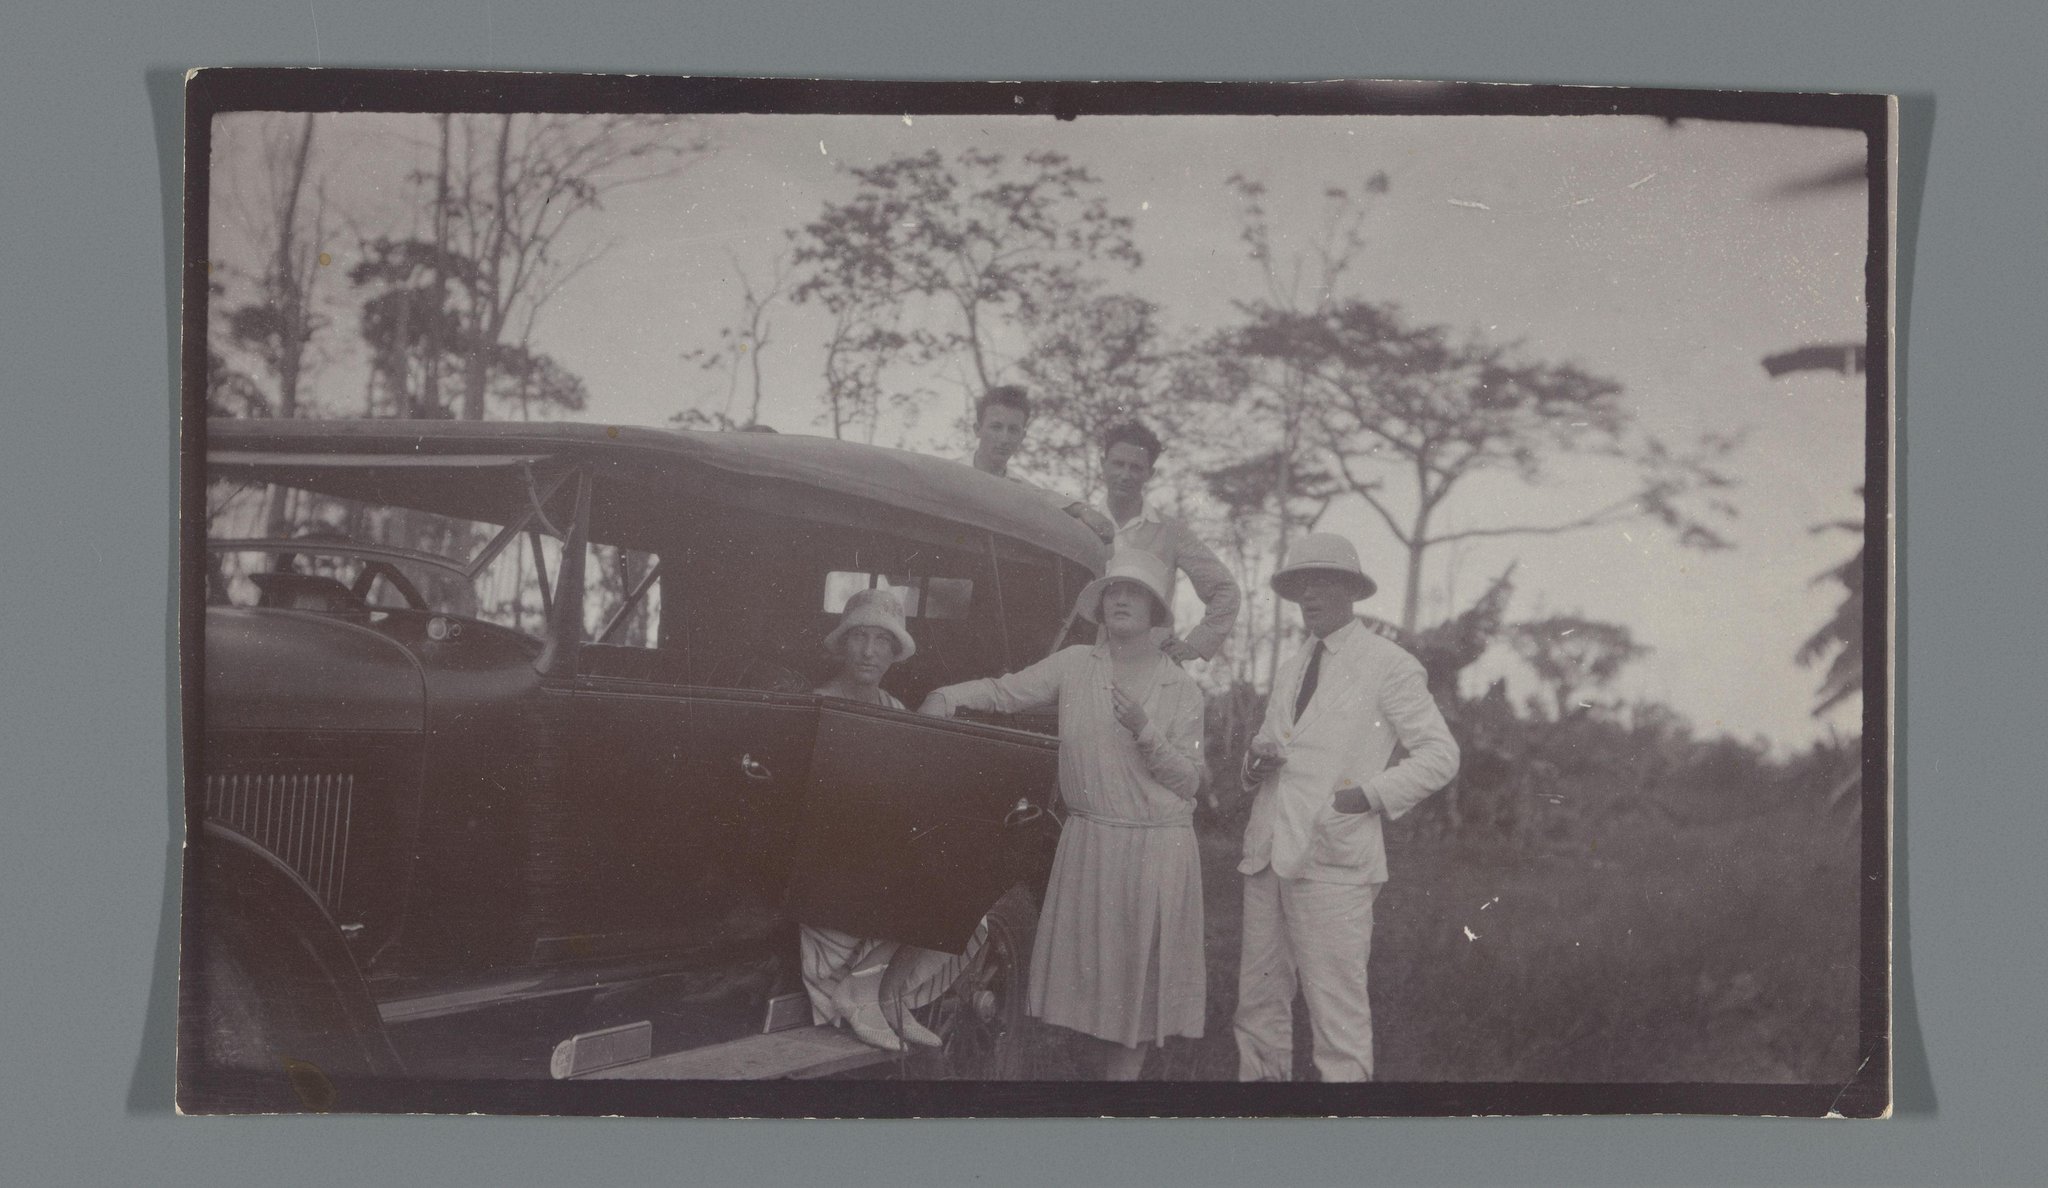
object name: photograph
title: Echtpaar Jetten bij een auto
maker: Anonymous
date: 1925-1927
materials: photographic support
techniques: photography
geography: suriname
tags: jetten, familie, moengo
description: Het echtpaar Jetten en drie andere personen bij een auto. Onderdeel van het ensemble met foto's van de familie van ingenieur Jetten in de mijnbouwstad Moengo in Suriname.